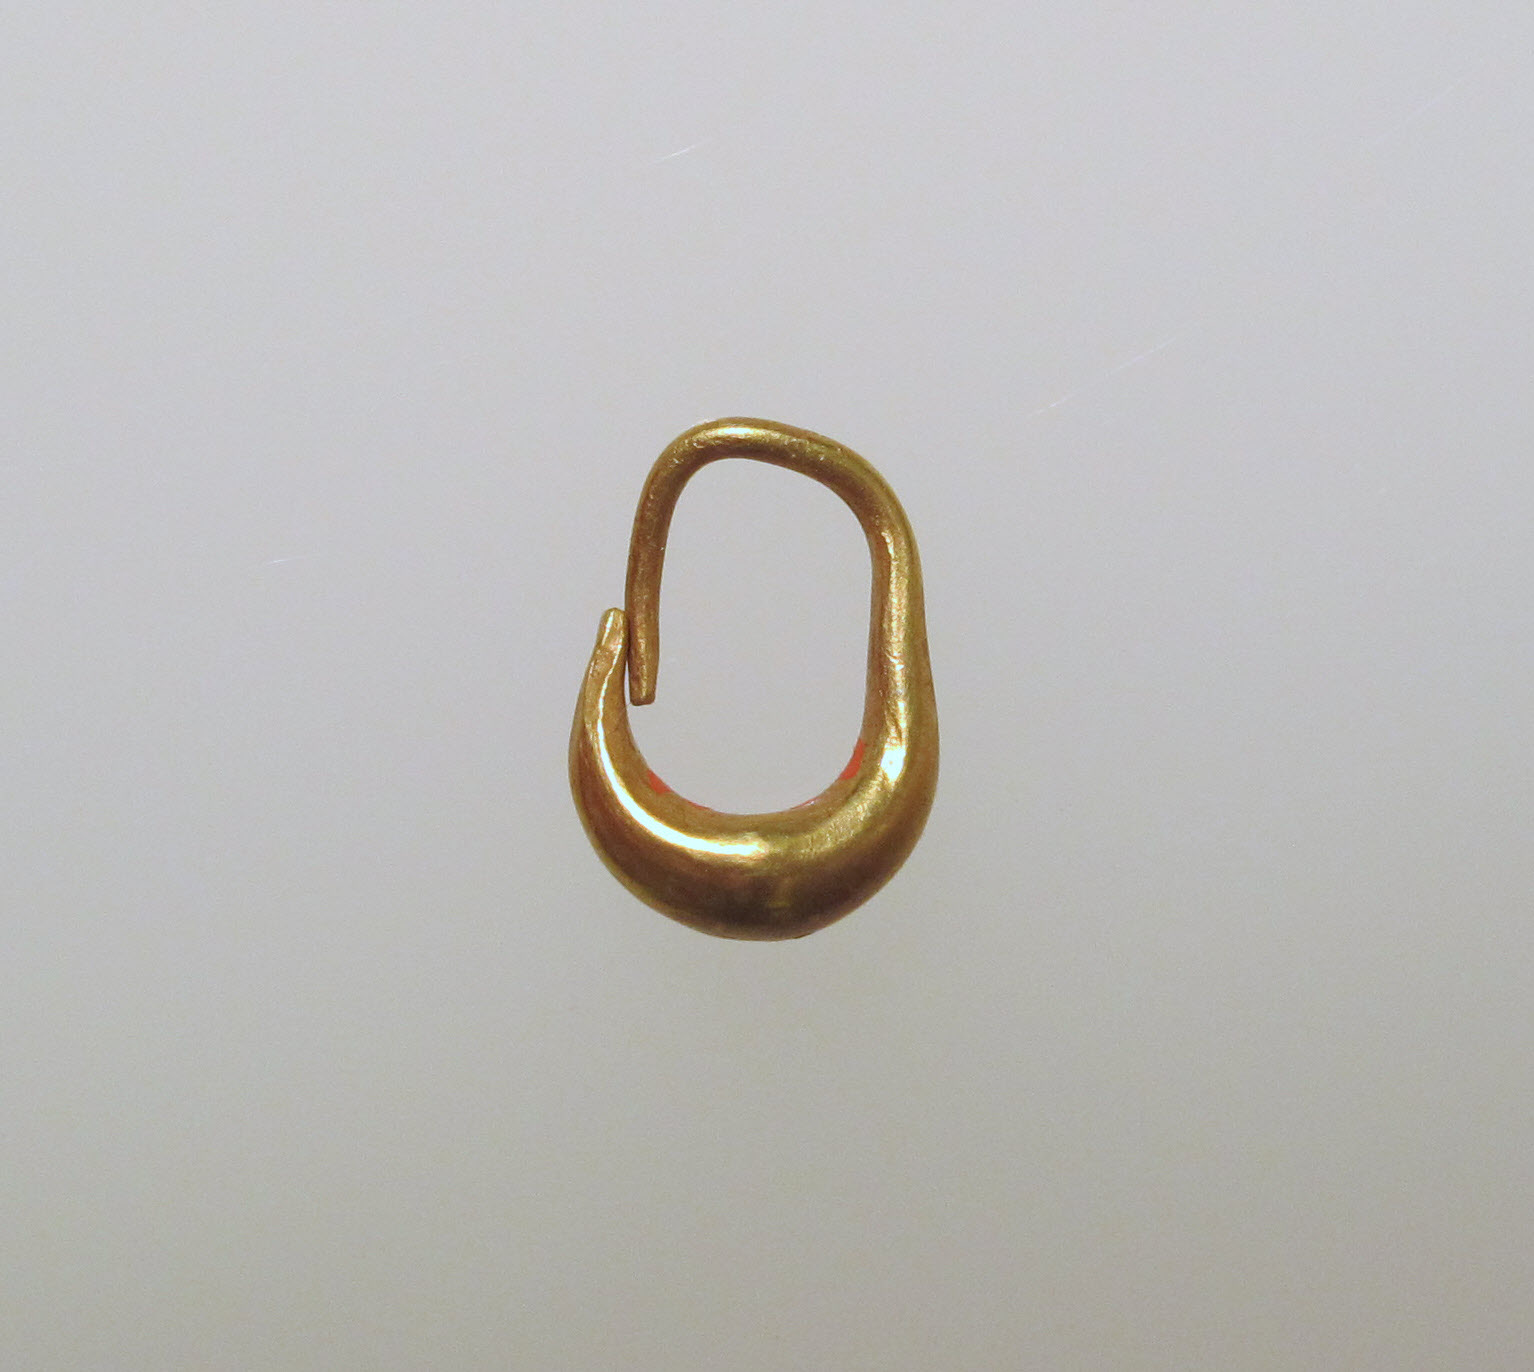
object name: earring, boat shaped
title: Earring, boat-shaped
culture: cypriot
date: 3900 BCE-100 CE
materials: gold